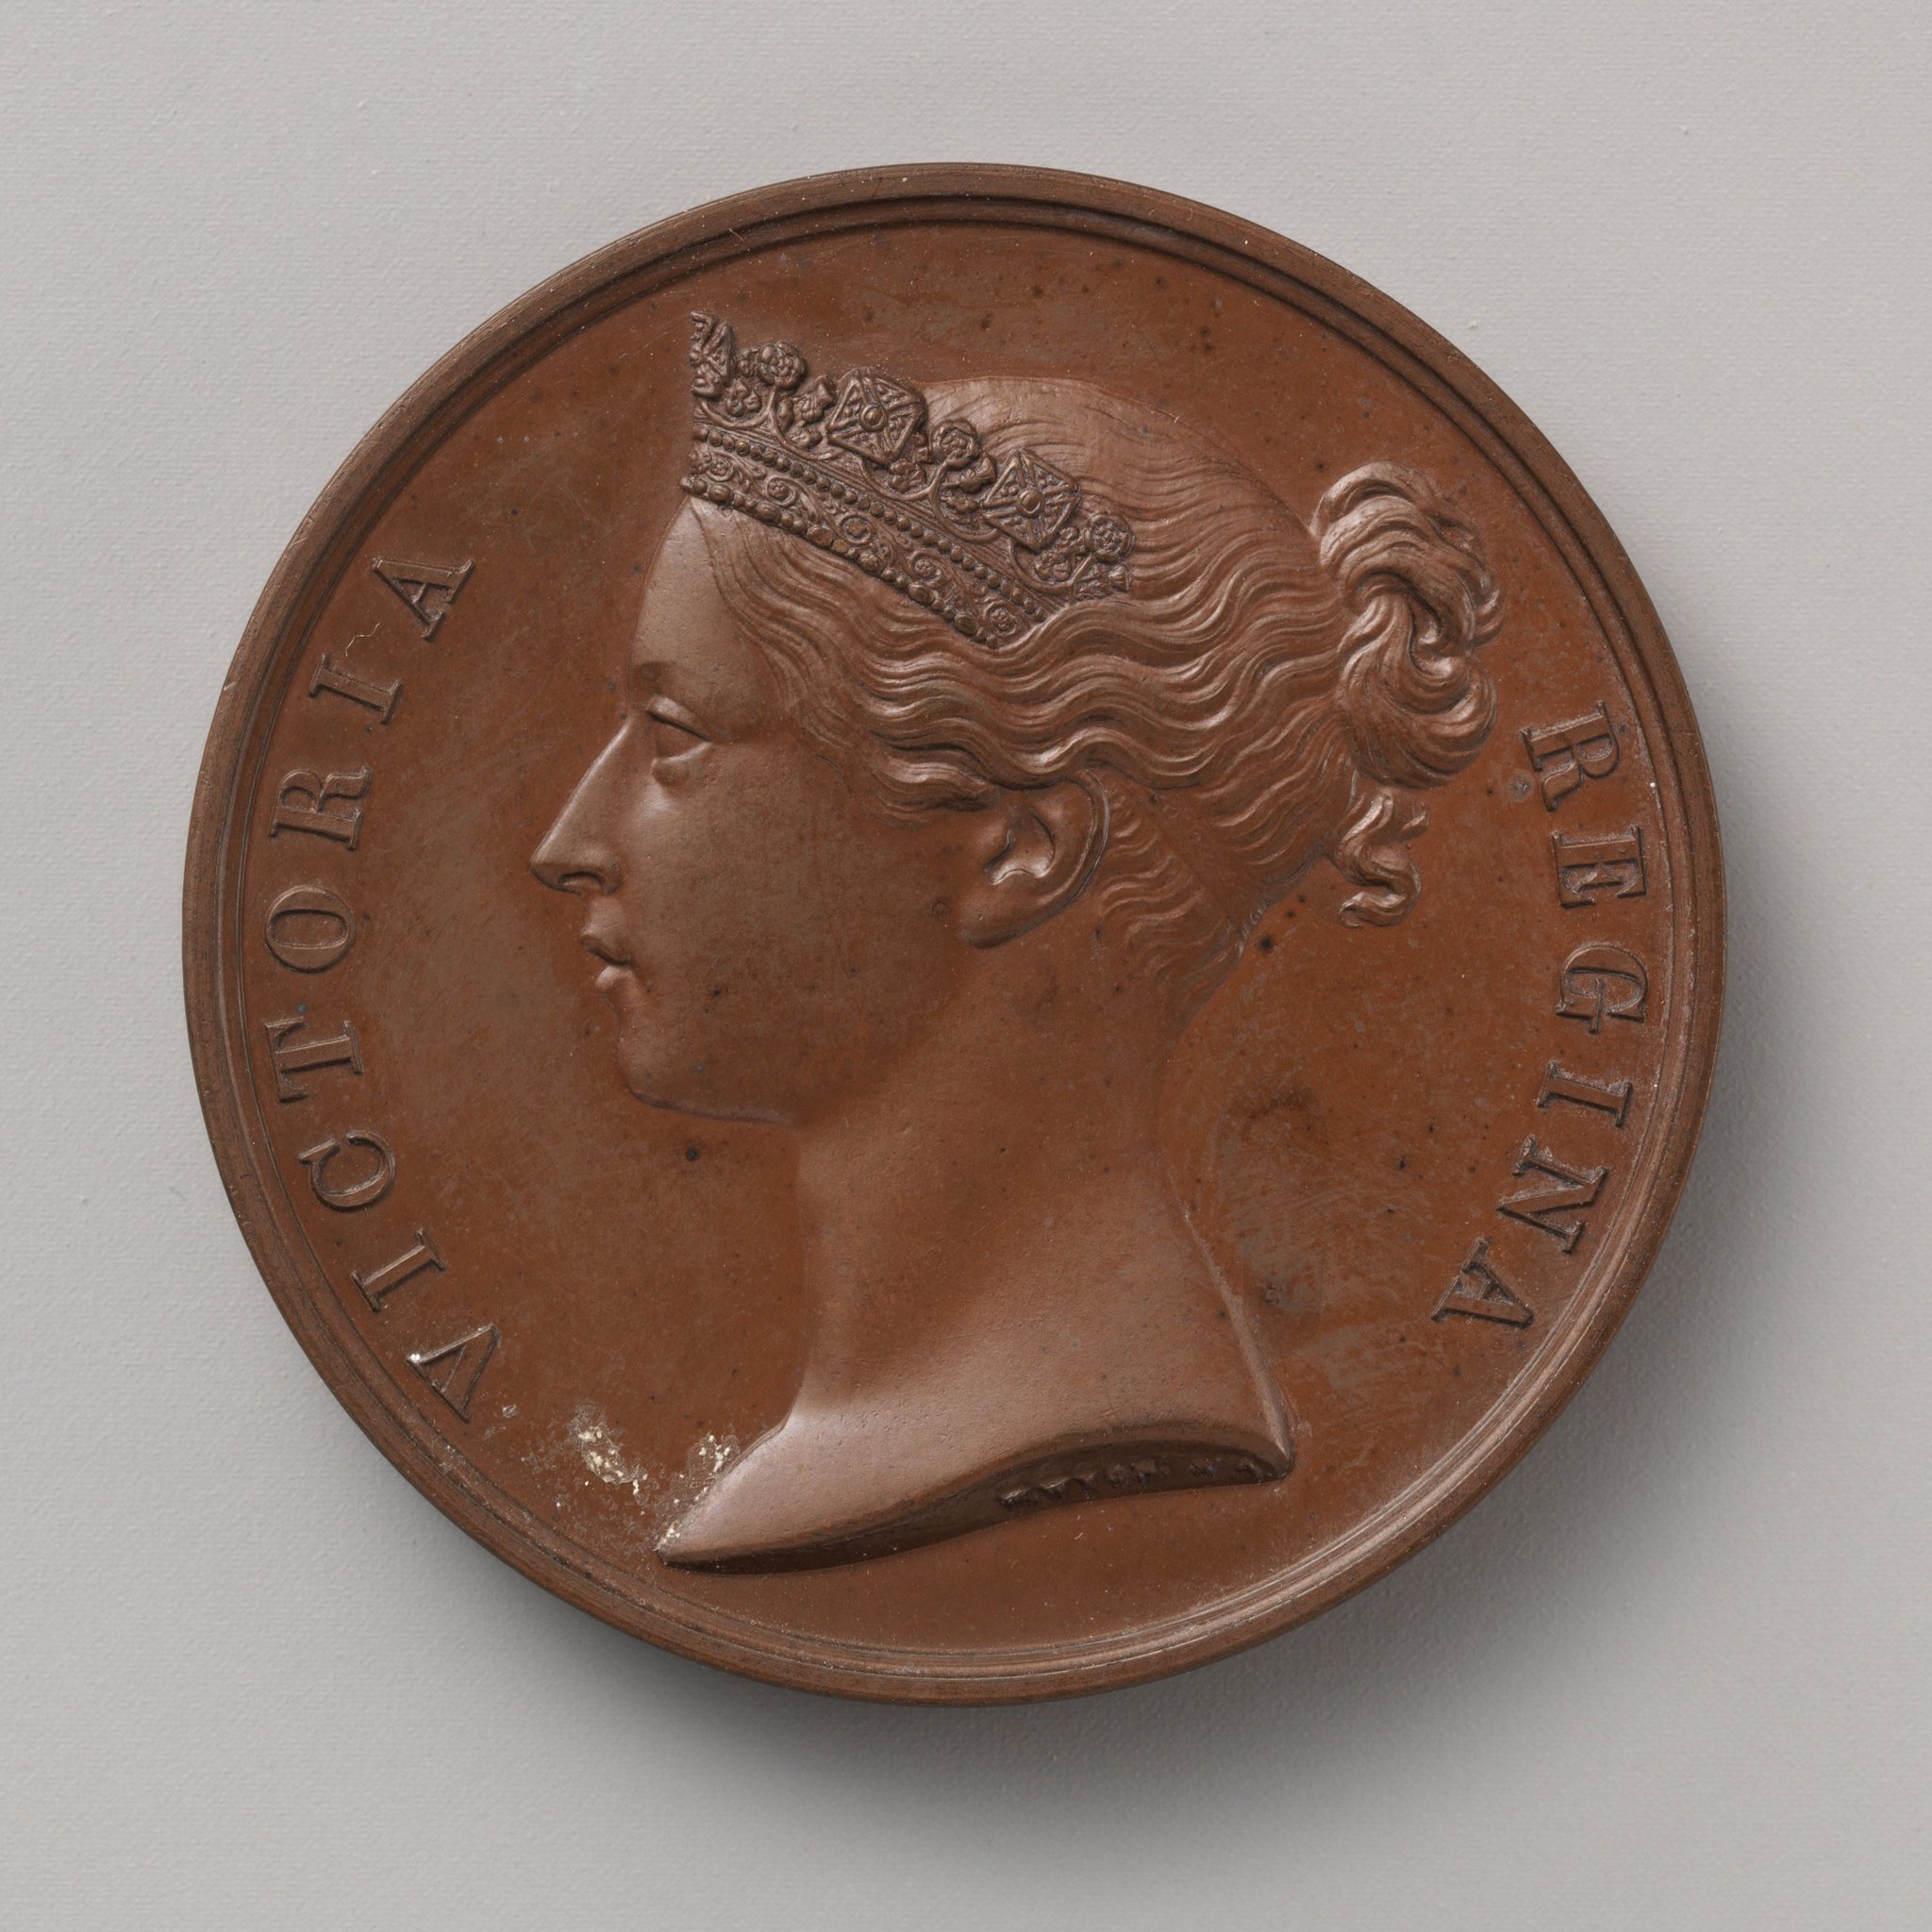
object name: medal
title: The Punjab Medal of 1848 and 1849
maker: william wyon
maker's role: artist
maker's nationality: british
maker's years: 1795-1851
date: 1849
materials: bronze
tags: shields,swords,women,horses